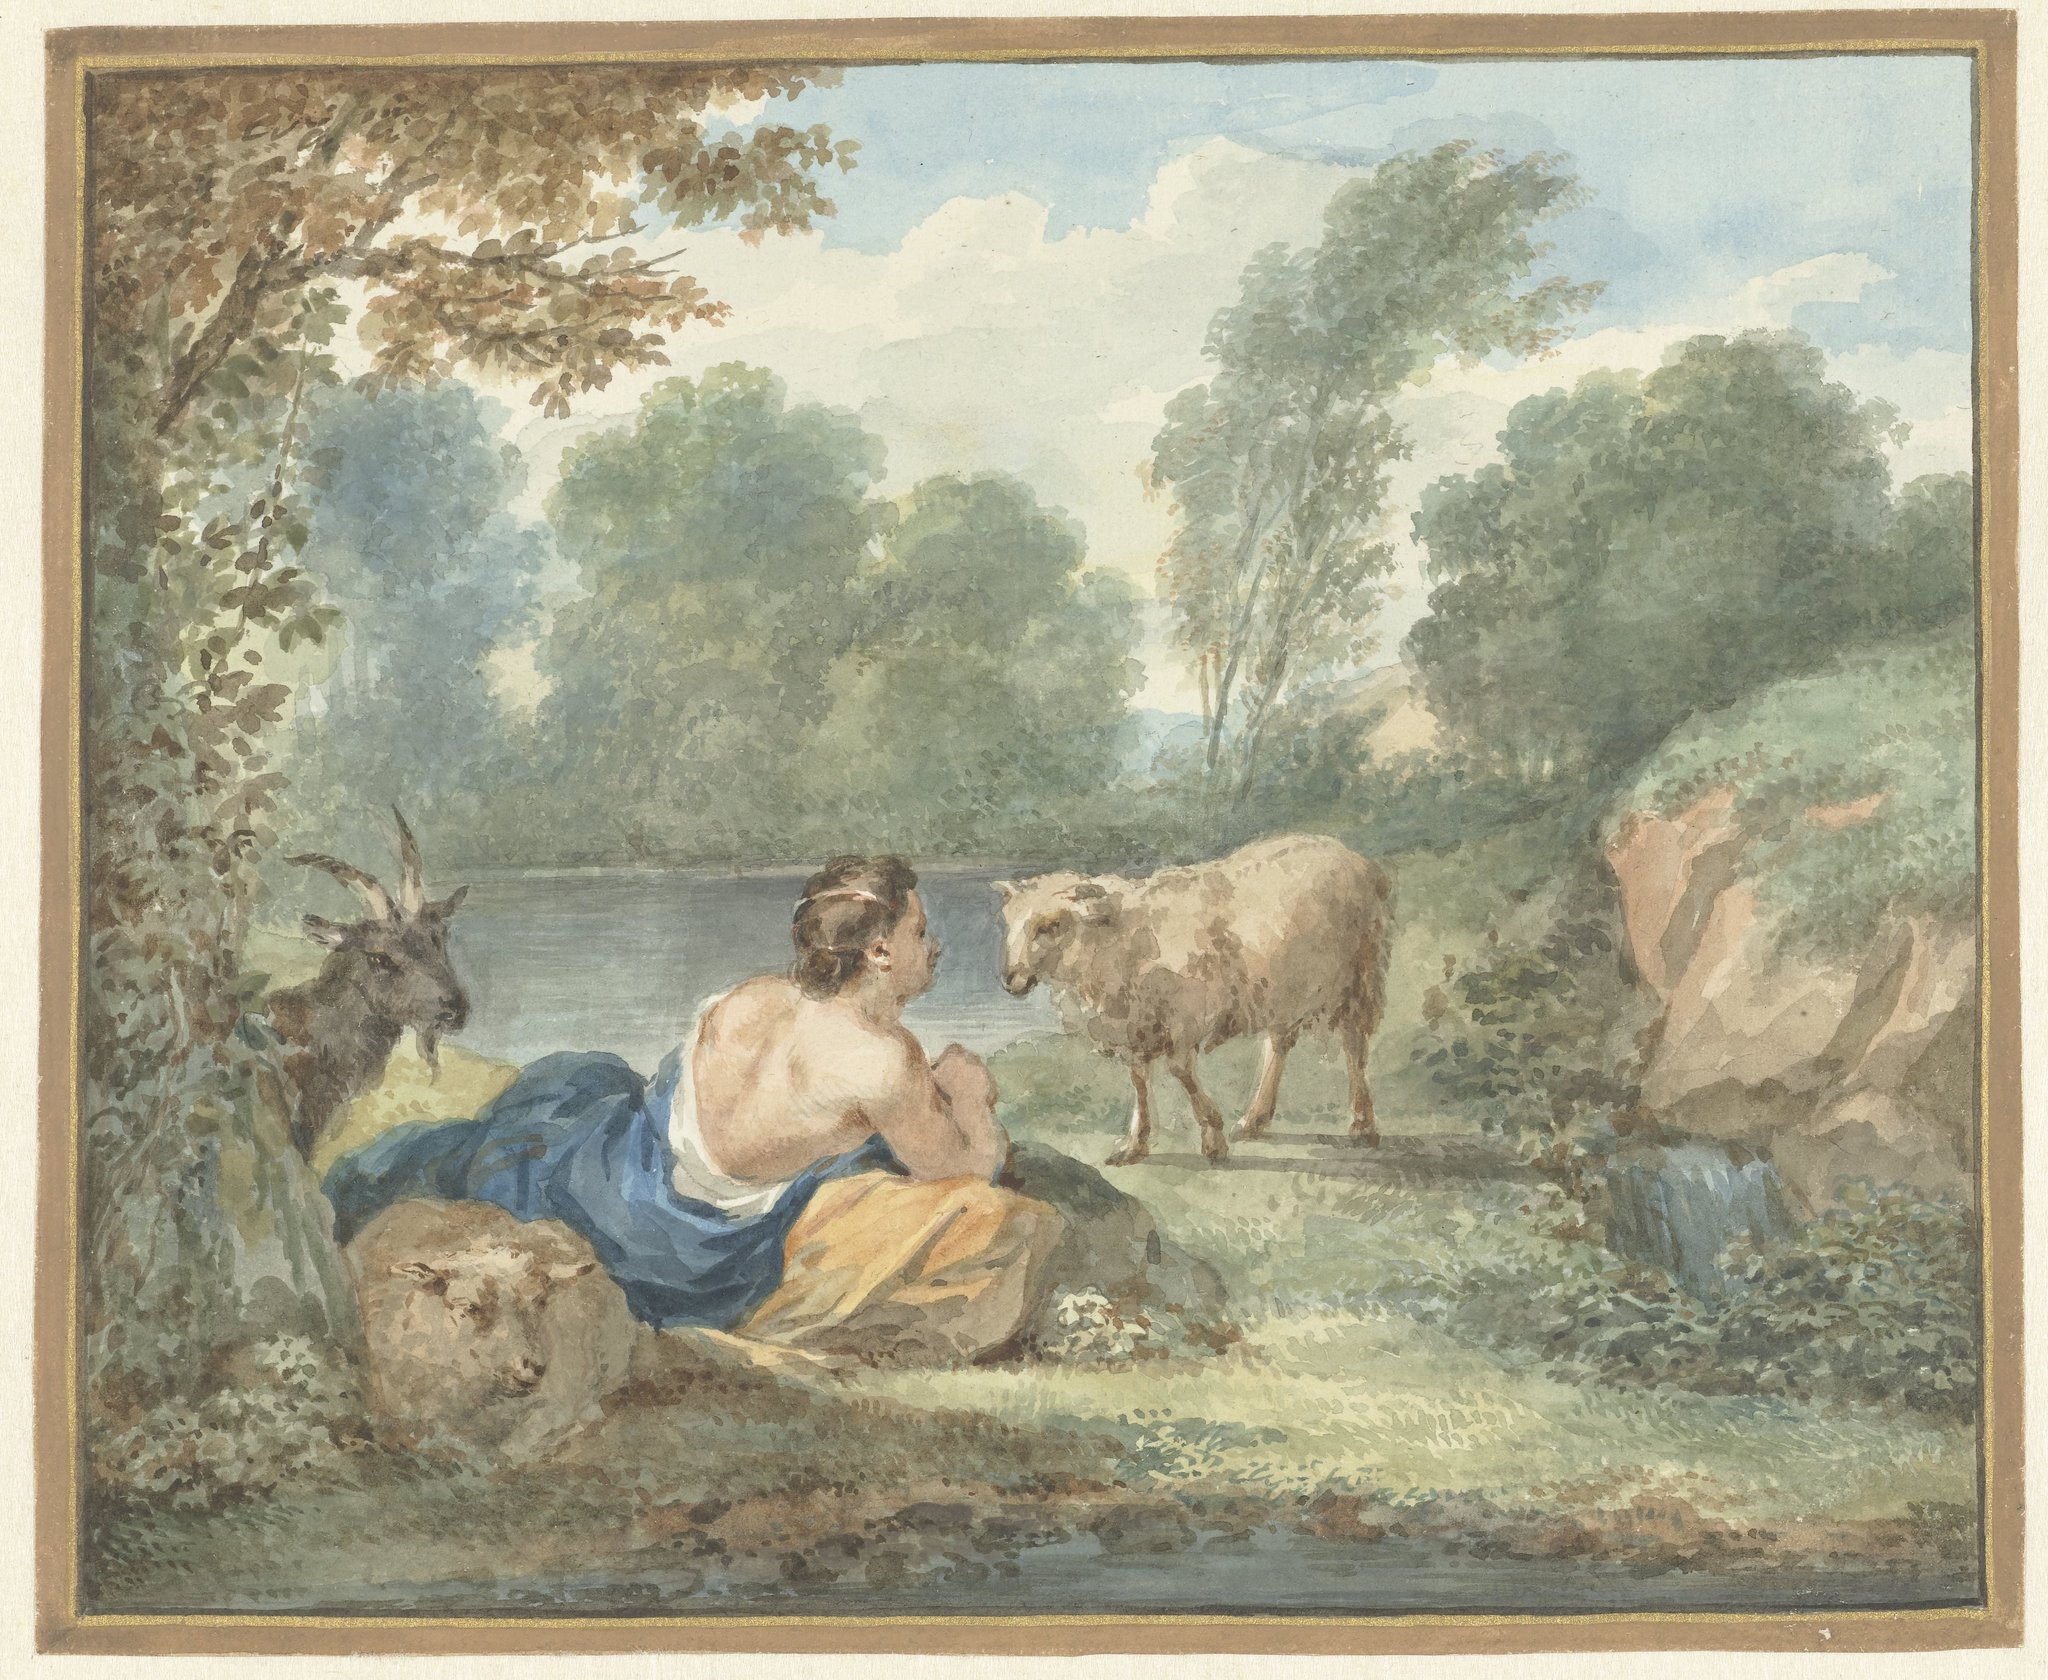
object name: drawing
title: Herderin met schapen in een landschap met een meertje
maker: aert schouman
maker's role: draughtsman, painter, print maker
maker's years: 1710-1792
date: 1781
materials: paint, paper, watercolor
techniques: brush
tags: landscapes, herding, herdsman, herdswoman, shepherd, shepherdess, cowherd, etc., sheep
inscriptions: inscription: ‘A. Schouman fecit na een stukje van S. v.d. Does 1781 welk stukje onder zijn berustende is’